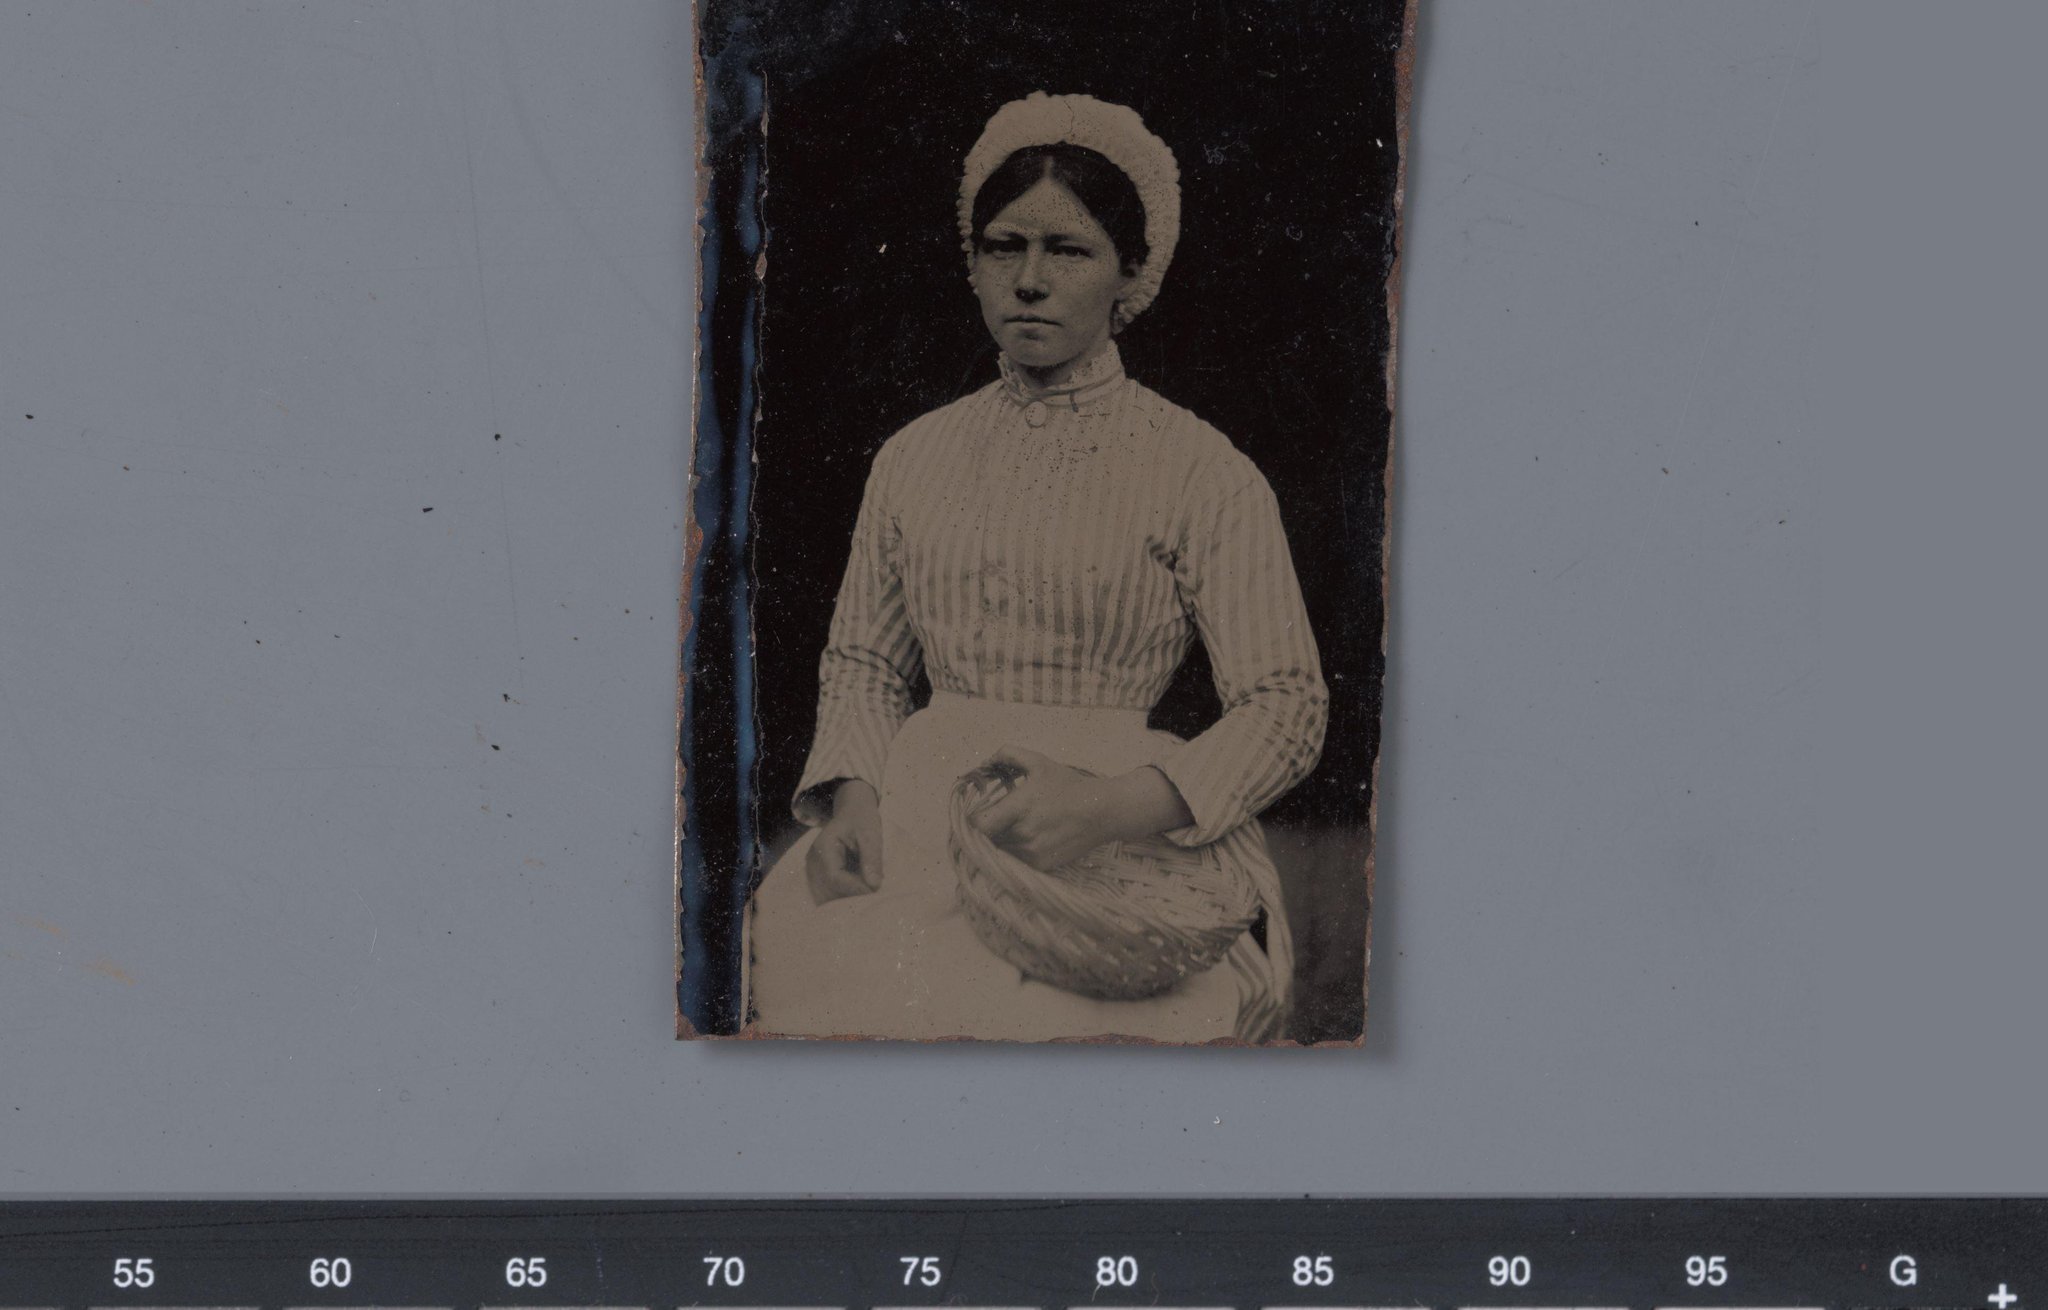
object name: photograph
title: Portret van een onbekende dienstbode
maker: Anonymous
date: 1855-1940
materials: iron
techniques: ferrotyping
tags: historical persons - bb - woman, maid ~ house personnel